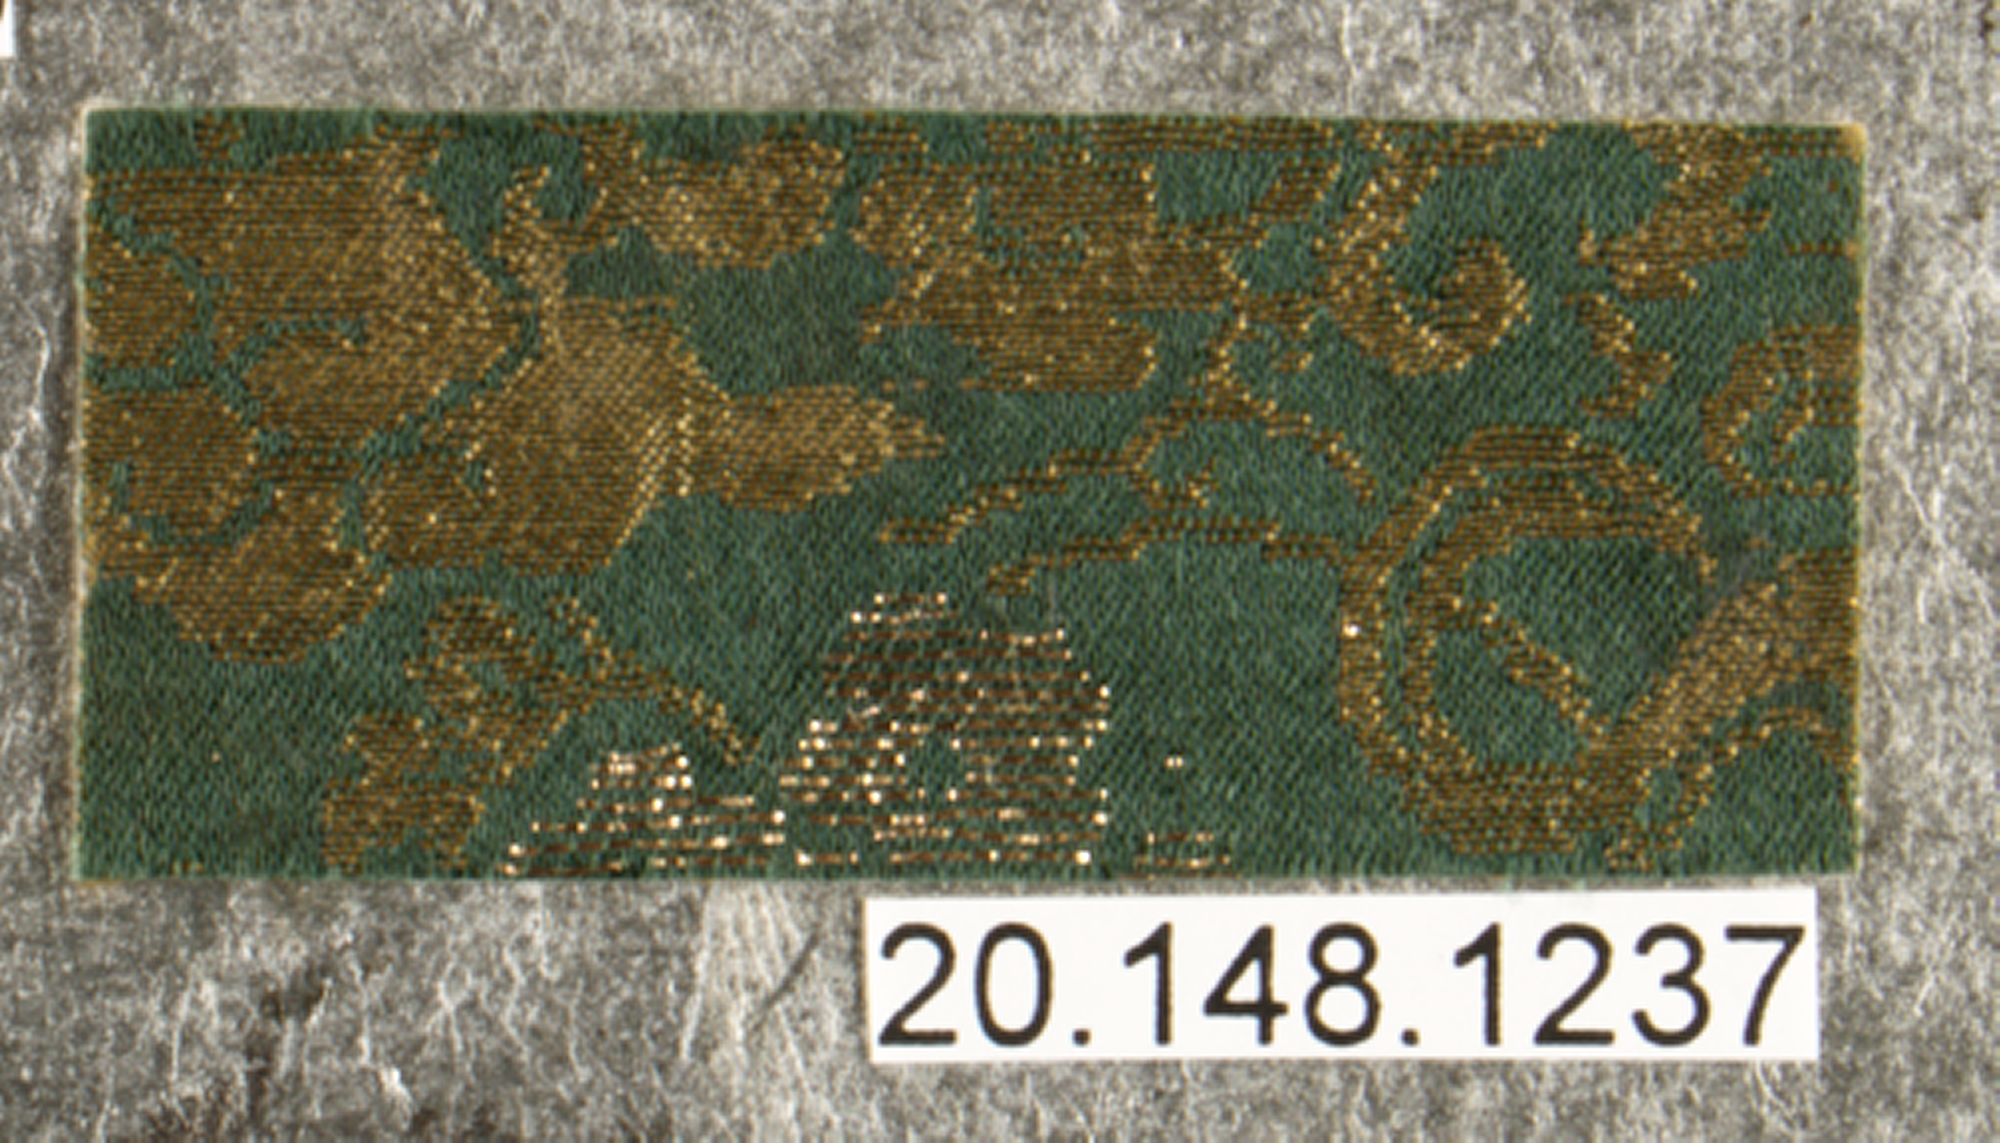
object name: piece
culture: japanese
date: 1801-1900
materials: silk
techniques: compound weave